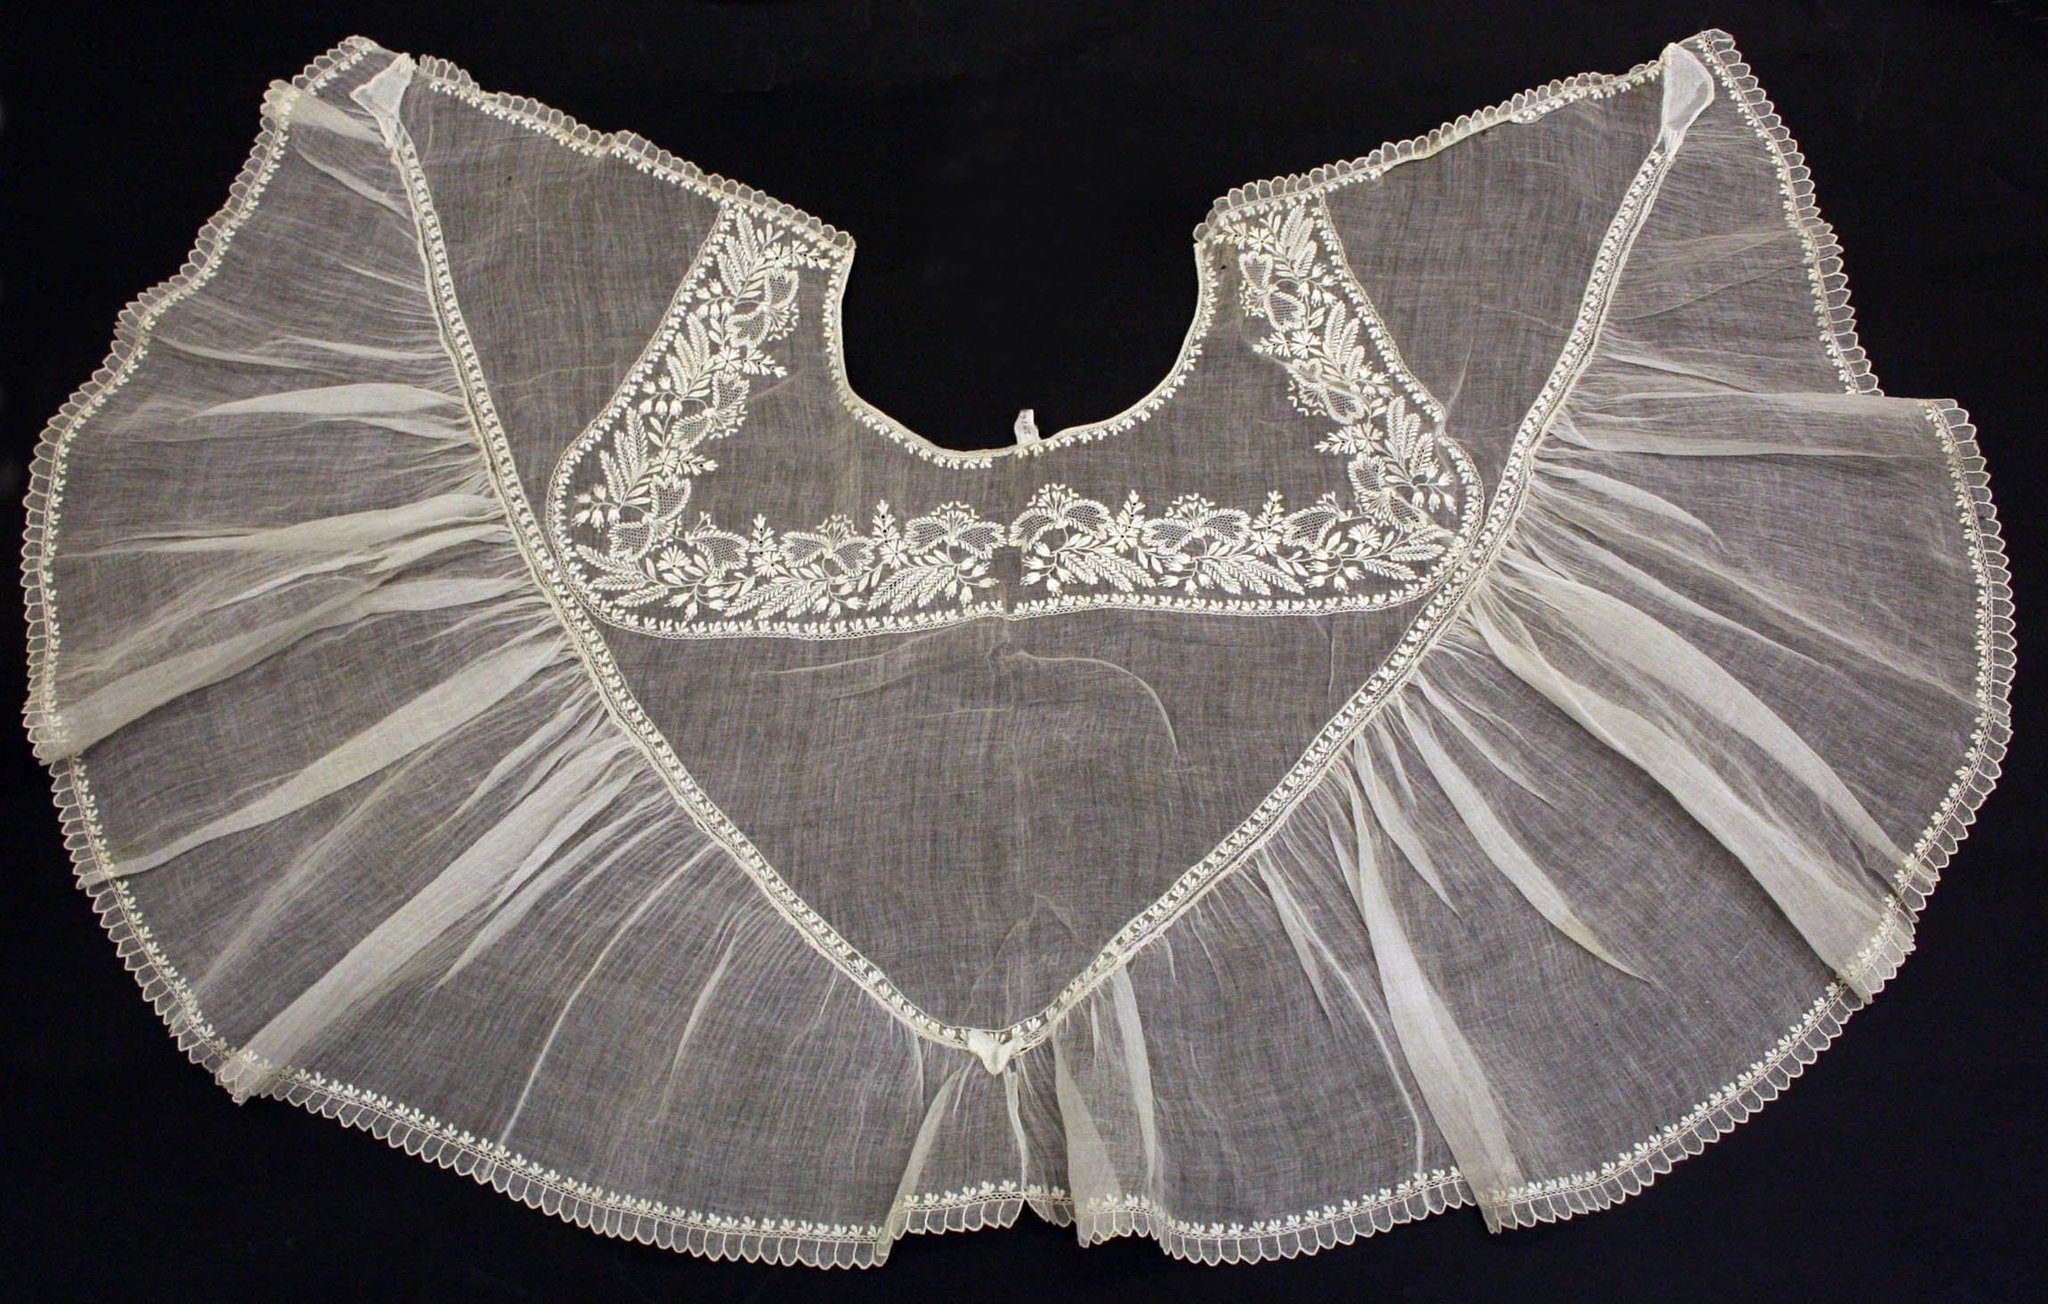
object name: collar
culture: american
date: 1830-1839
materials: cotton